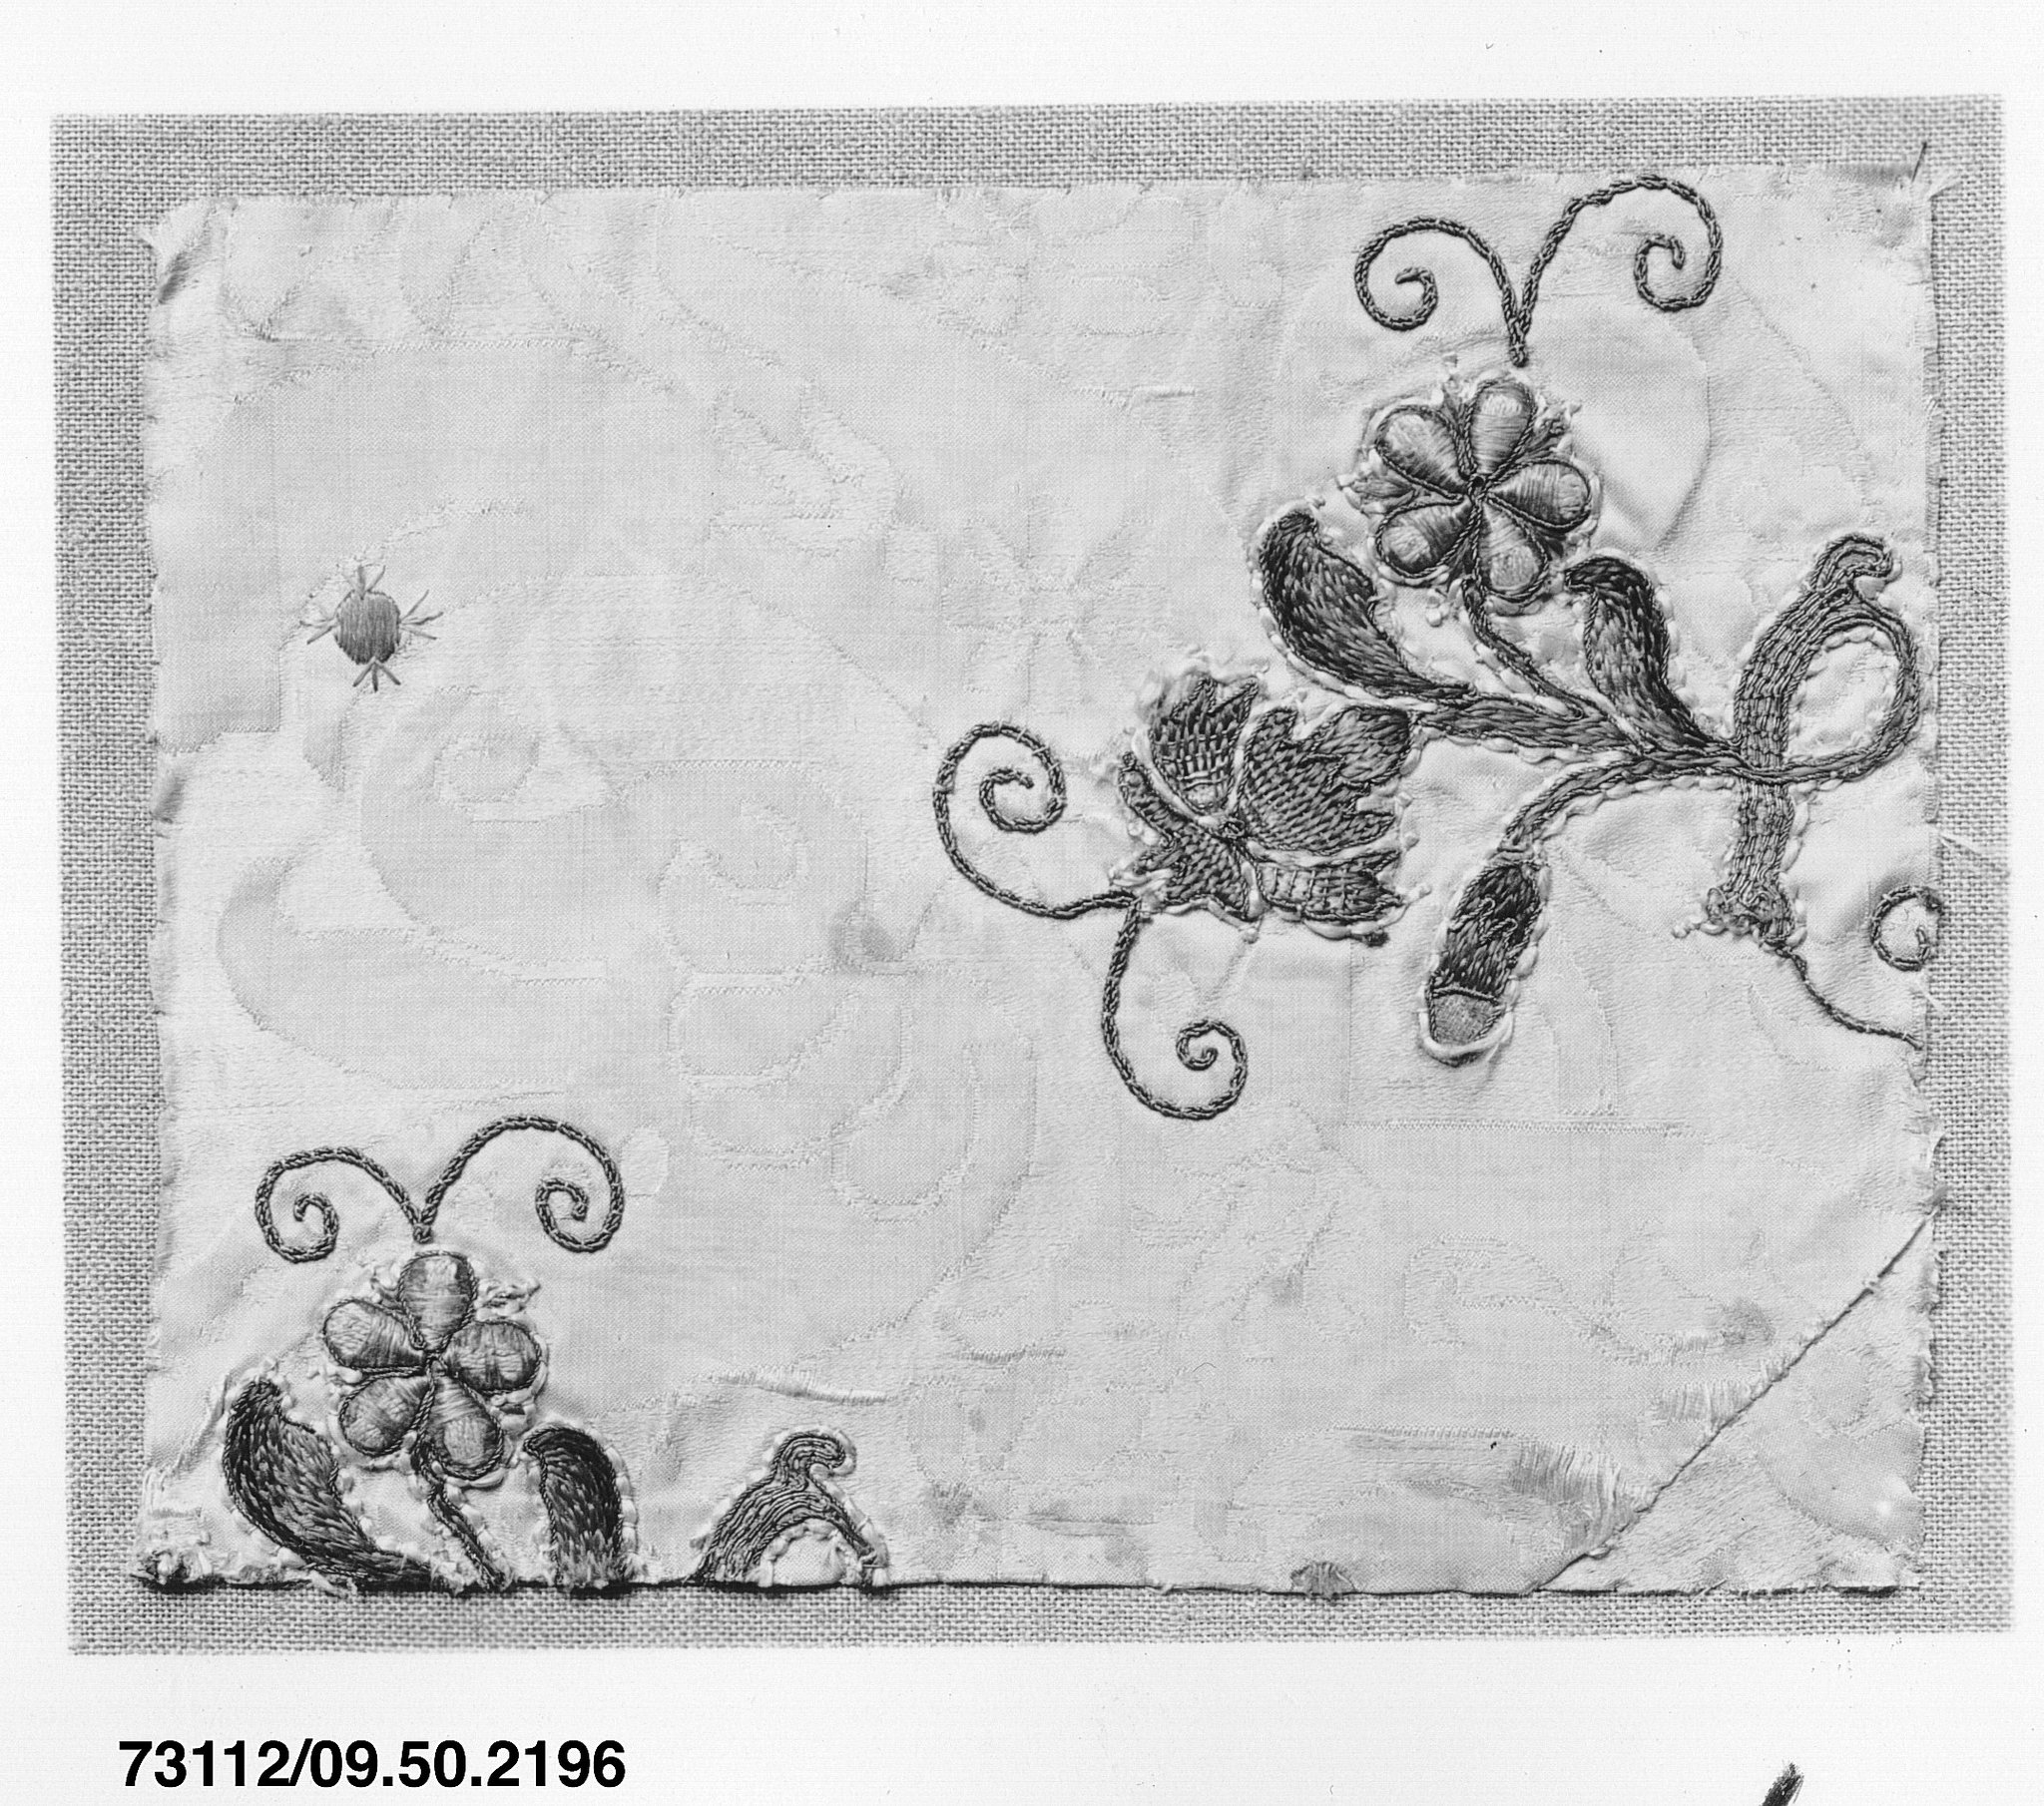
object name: fragment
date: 1601-1800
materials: metal thread, silk